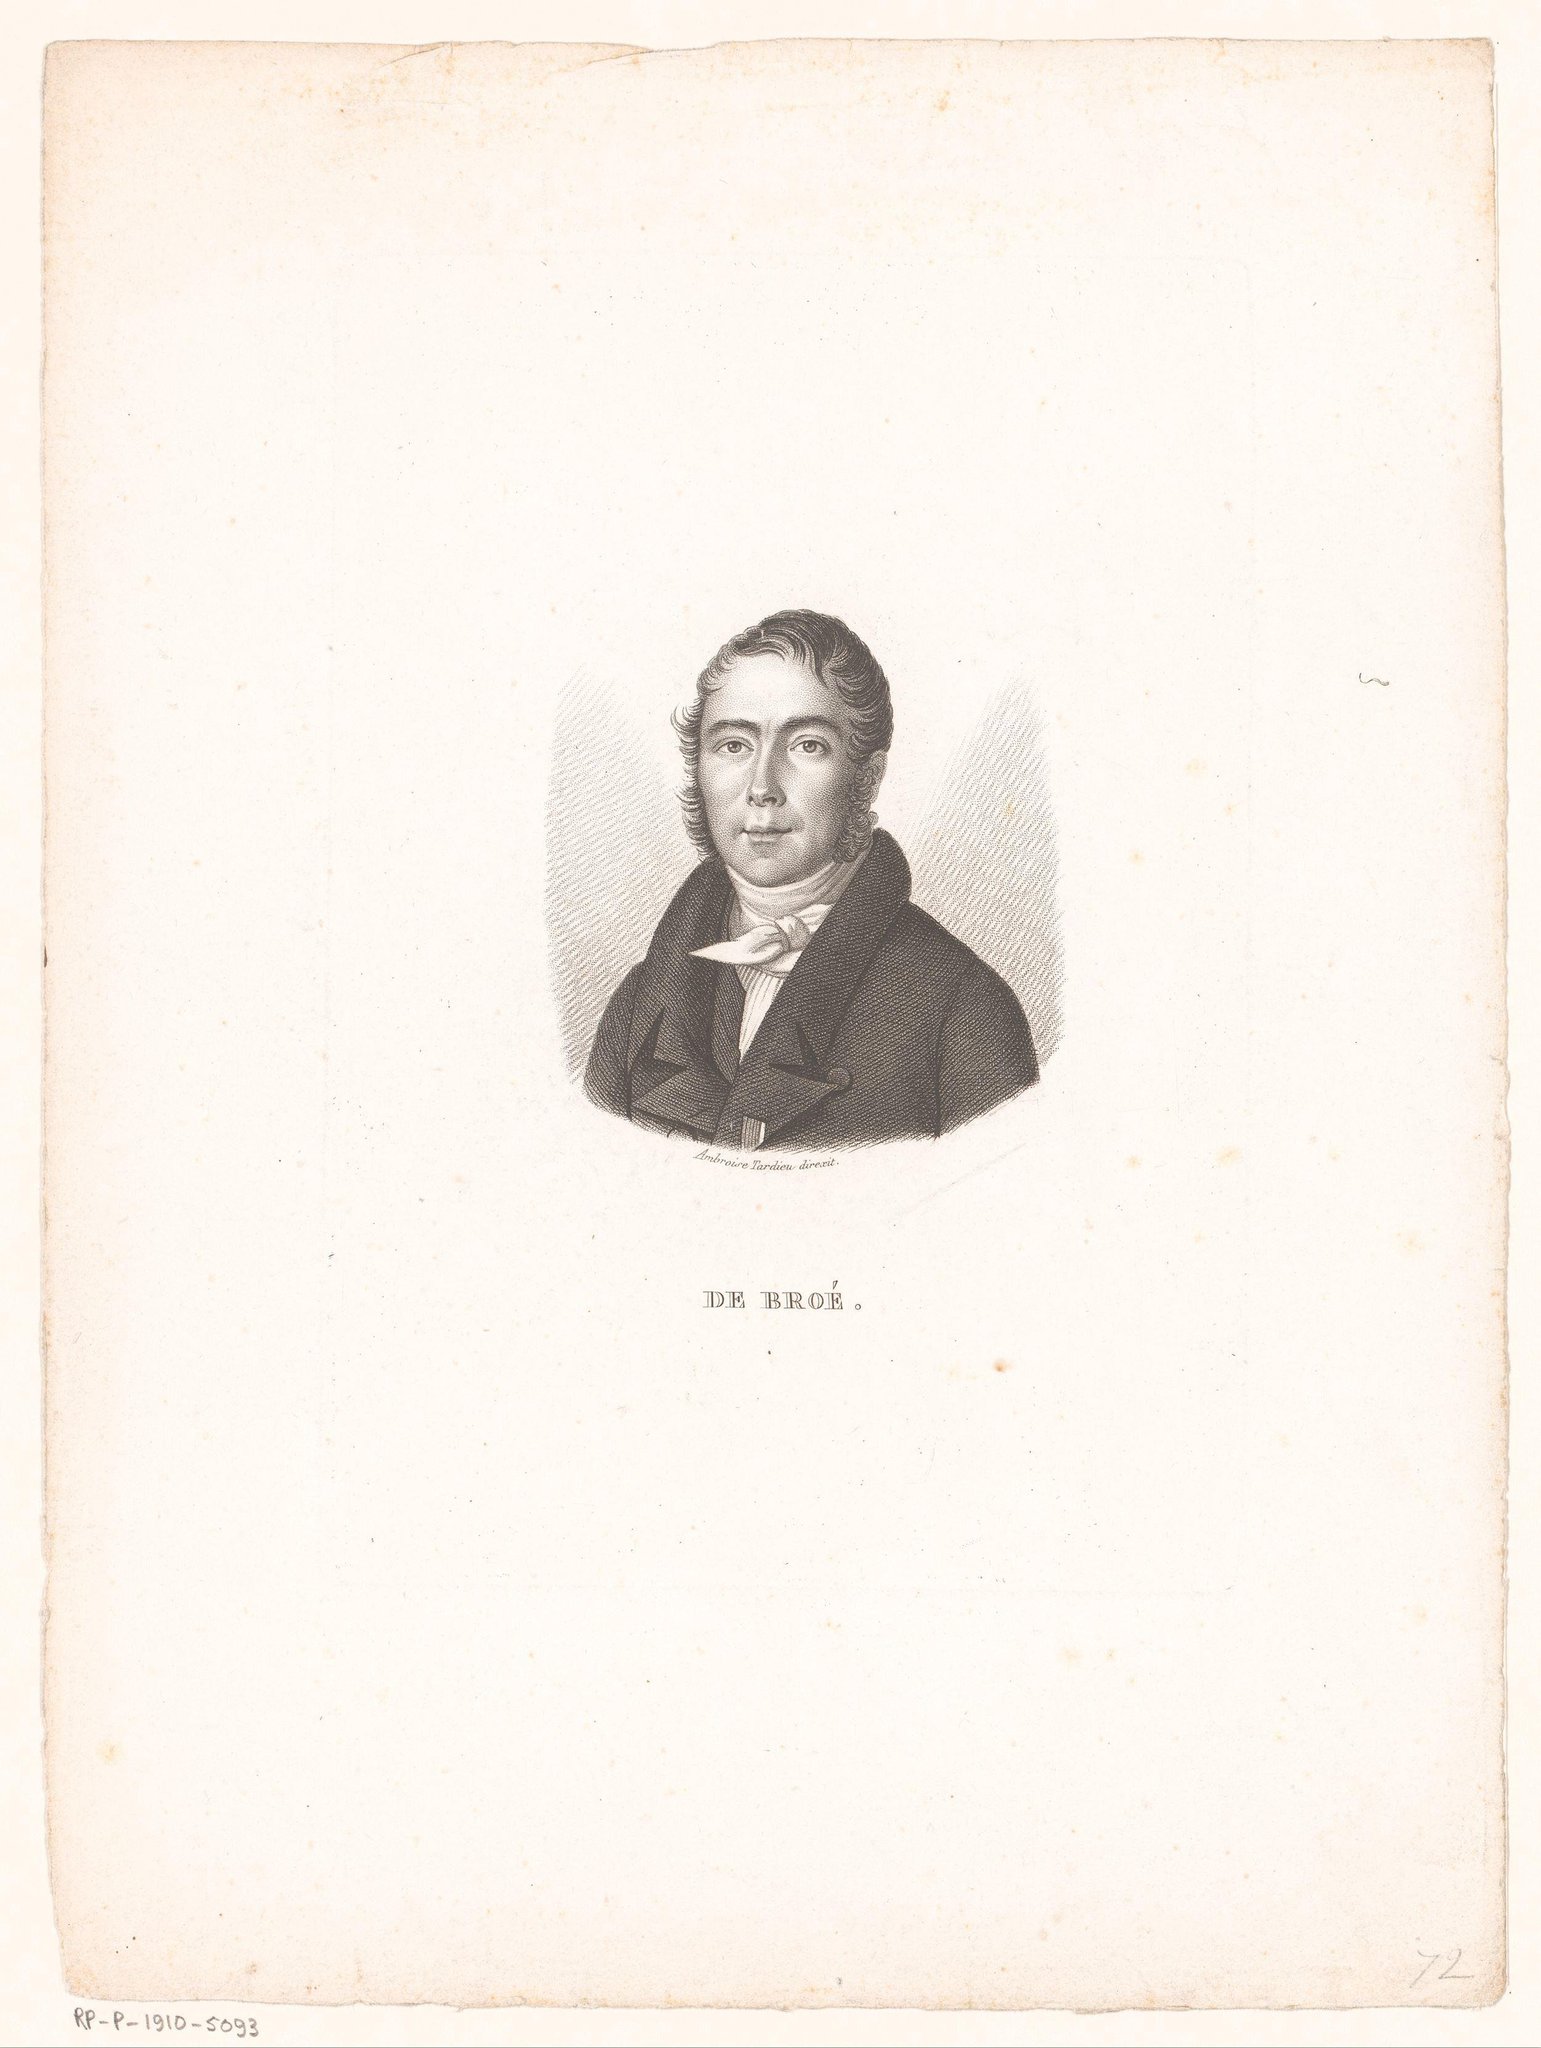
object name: book illustration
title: Portret van De Broé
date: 1818-1832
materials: paper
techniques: engraving, roulette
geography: paris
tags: historical persons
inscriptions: collector's mark: Lugt 2228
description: Mogelijk prent uit: Journal complémentaire du Dictionnaire des sciences médicales. Parijs: Panckoucke, Charles Louis Fleury, 1818-1832.